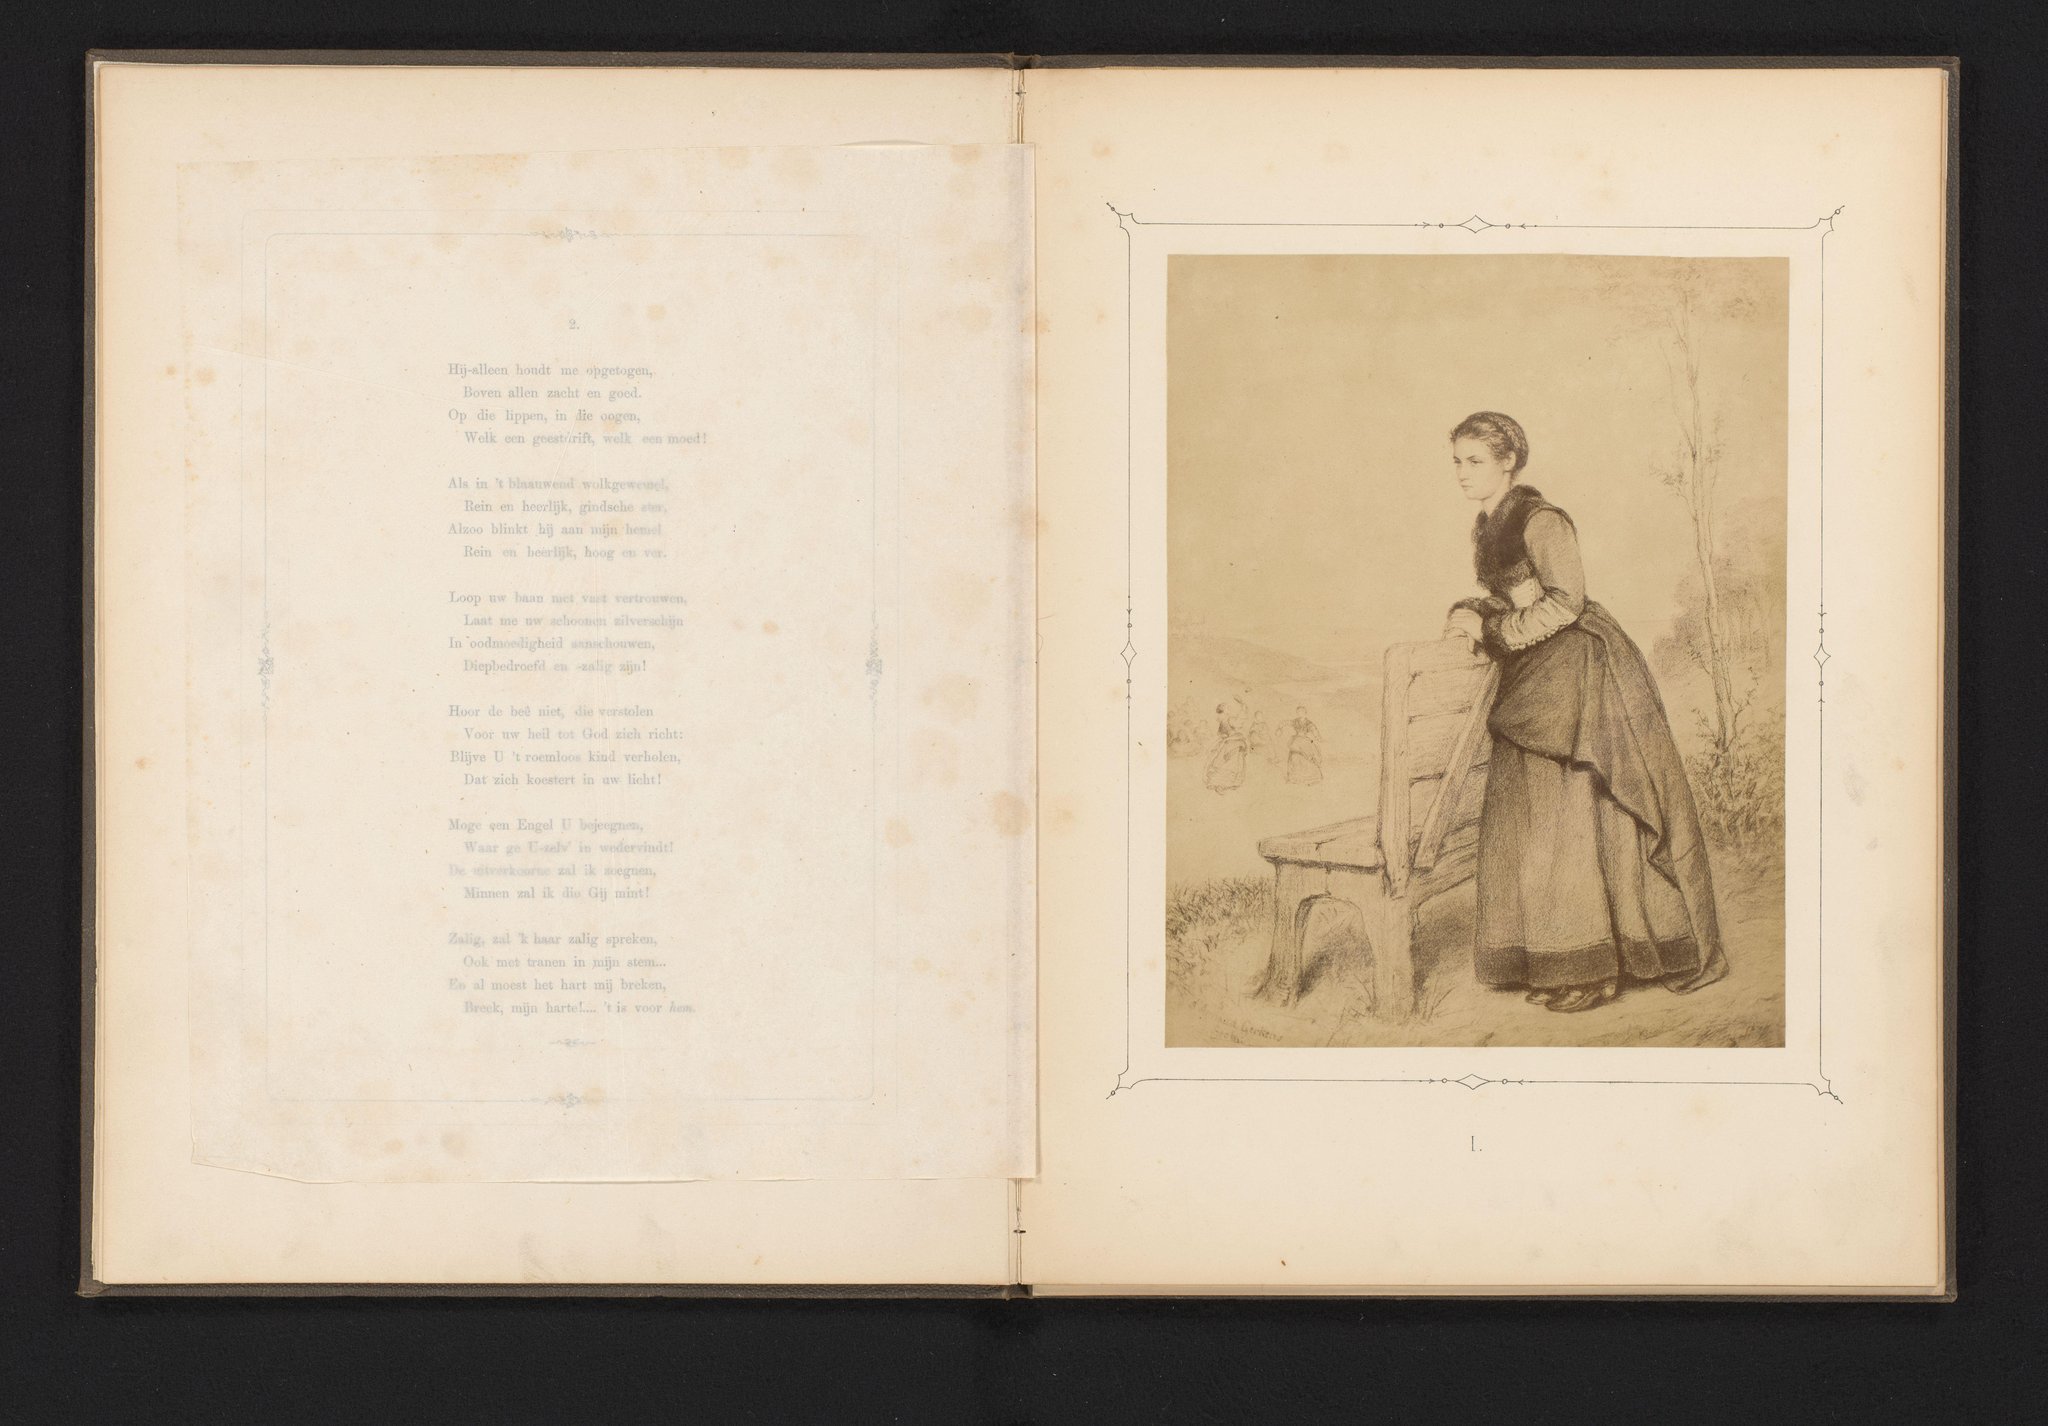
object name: page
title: Fotoreproductie van een tekening van een jonge vrouw door Johannes Christiaan d'Arnaud Gerkens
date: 1858-1863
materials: paper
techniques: albumen print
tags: adolescent, young woman, maiden